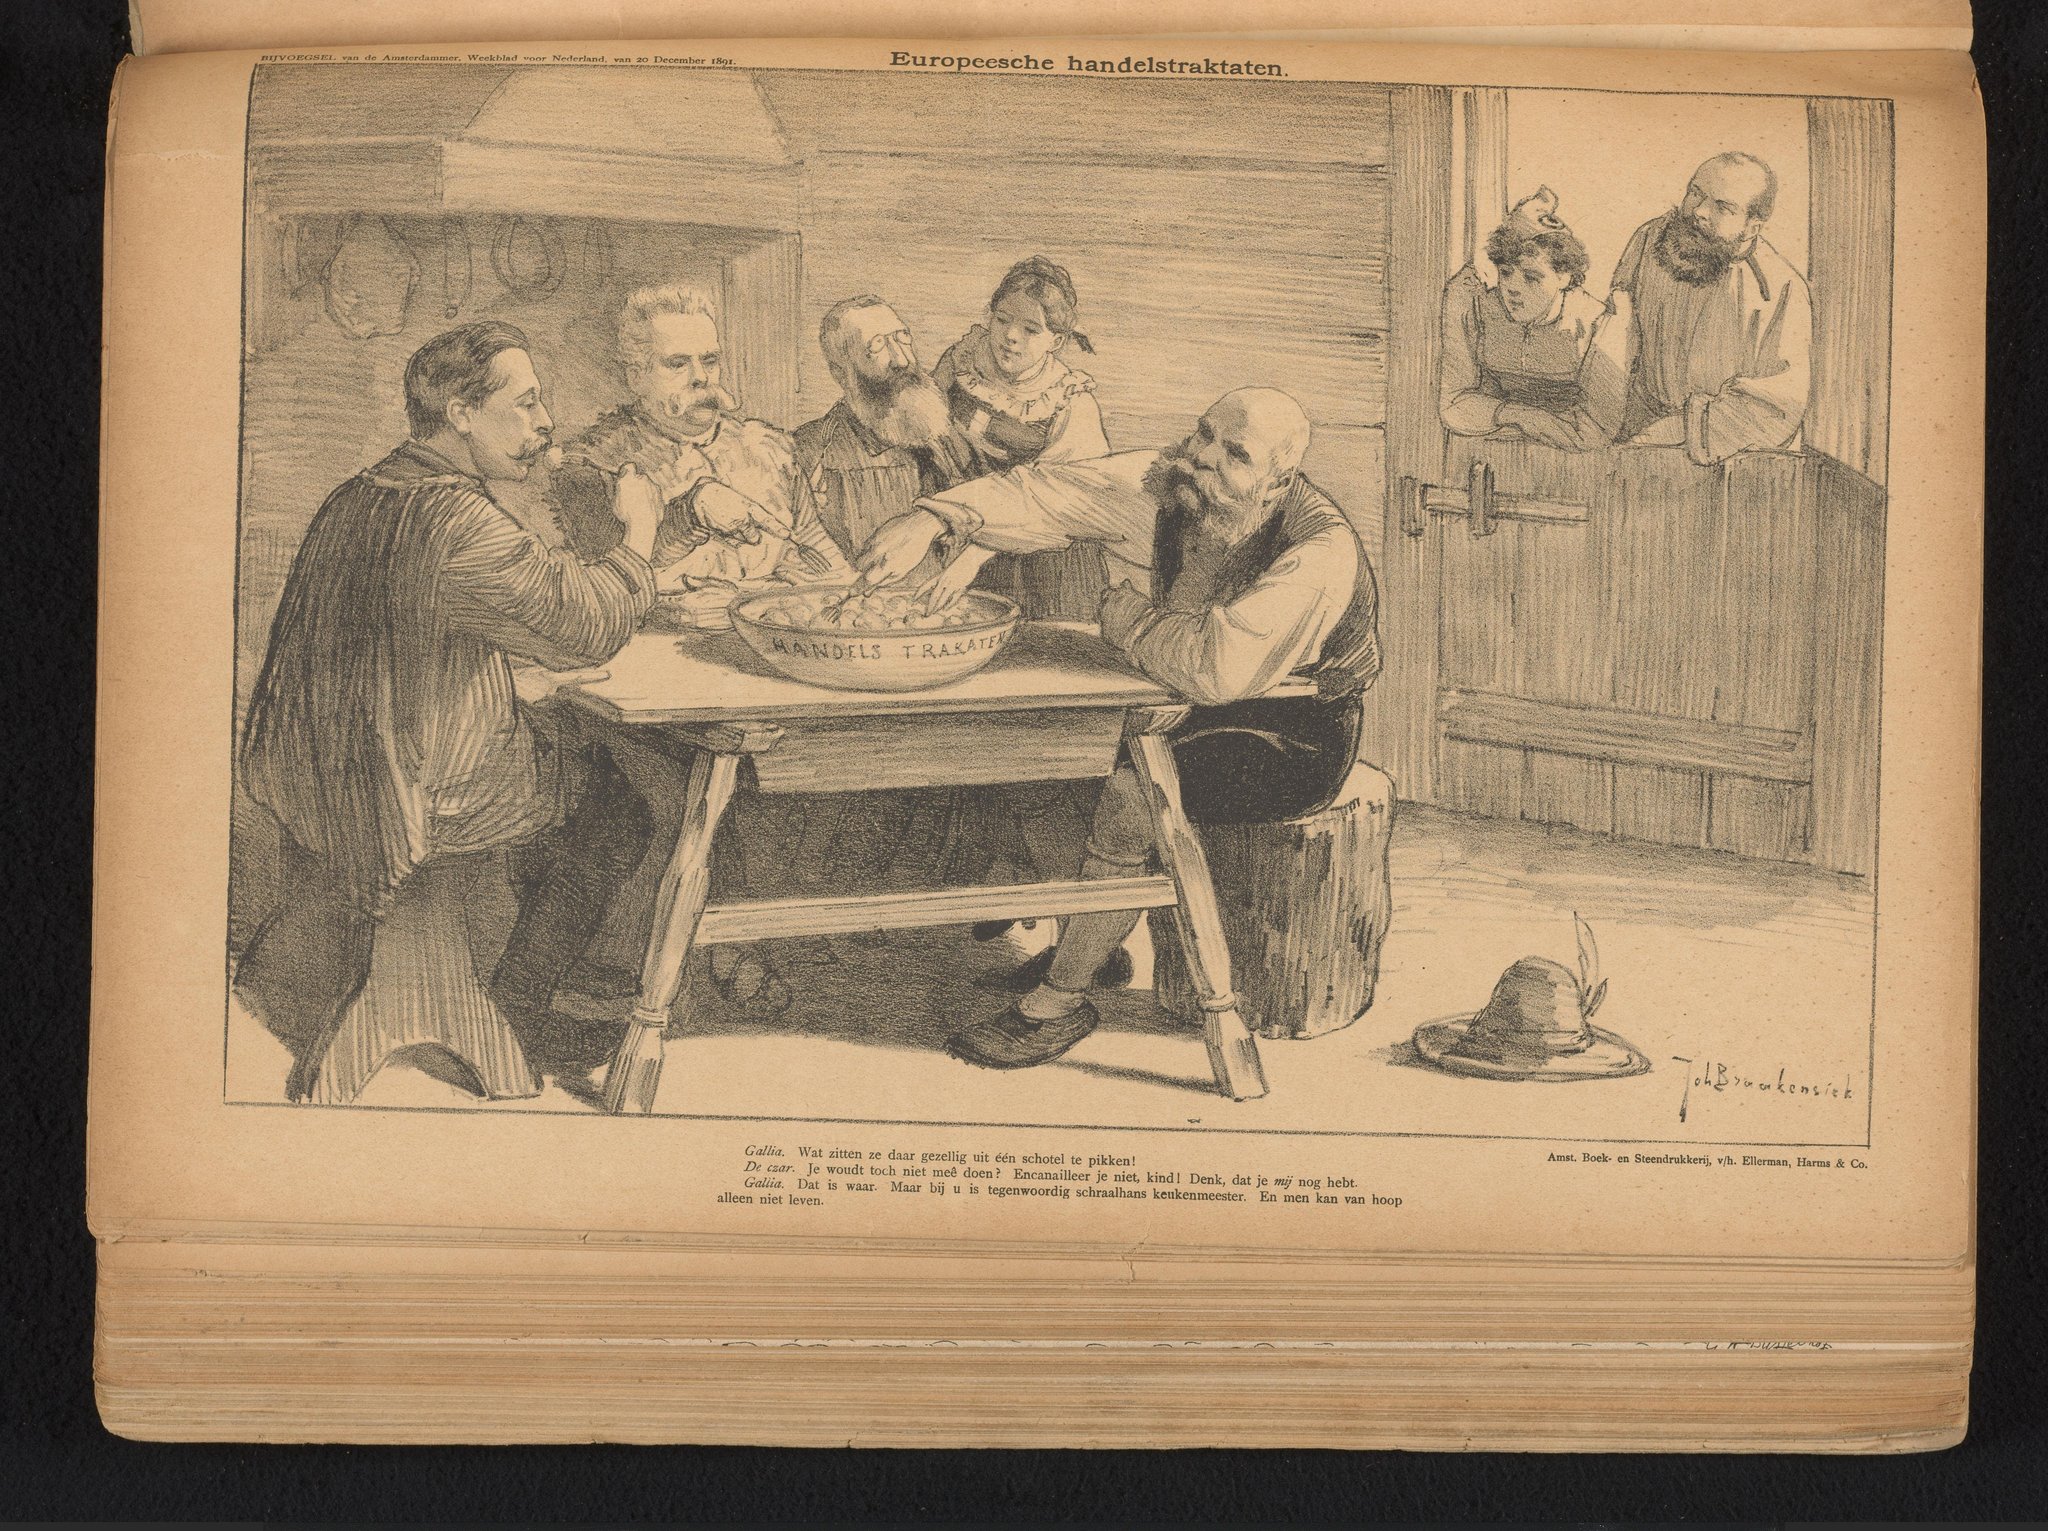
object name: cartoon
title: Europeesche handelstraktaten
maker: johan braakensiek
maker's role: draughtsman, print maker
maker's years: 1858-1940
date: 1891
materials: paper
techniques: lithograph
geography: netherlands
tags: brussels, leopold ii (koning der belgen), vienna, wilhelm ii (keizer van duitsland), personifications of countries, nations, states, districts, etc. (+ nation; national), eating, political caricatures and satires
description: Gallia (Frankrijk) en de Russische tsaar Alexander III kijken over de halve deur naar binnen hoe de andere Europese leiders samen uit één schotel van de handelstraktaten eten.